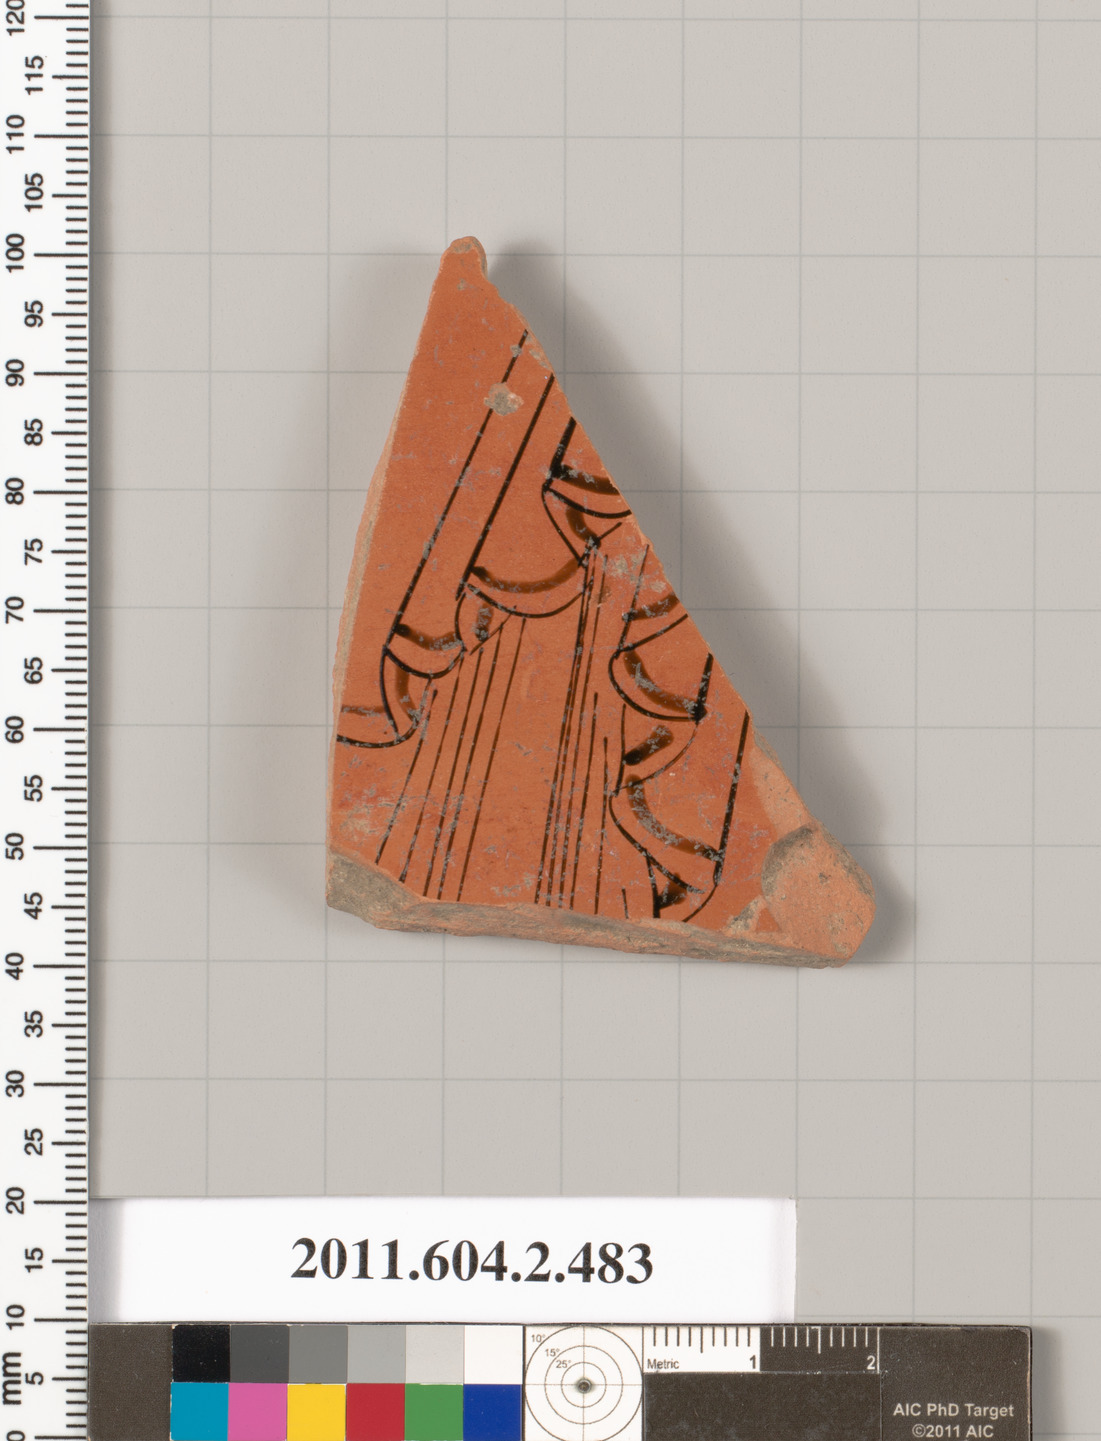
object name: column krater fragment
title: Terracotta fragment of a column-krater (bowl for mixing wine and water)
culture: greek, attic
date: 460-450 BCE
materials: terracotta